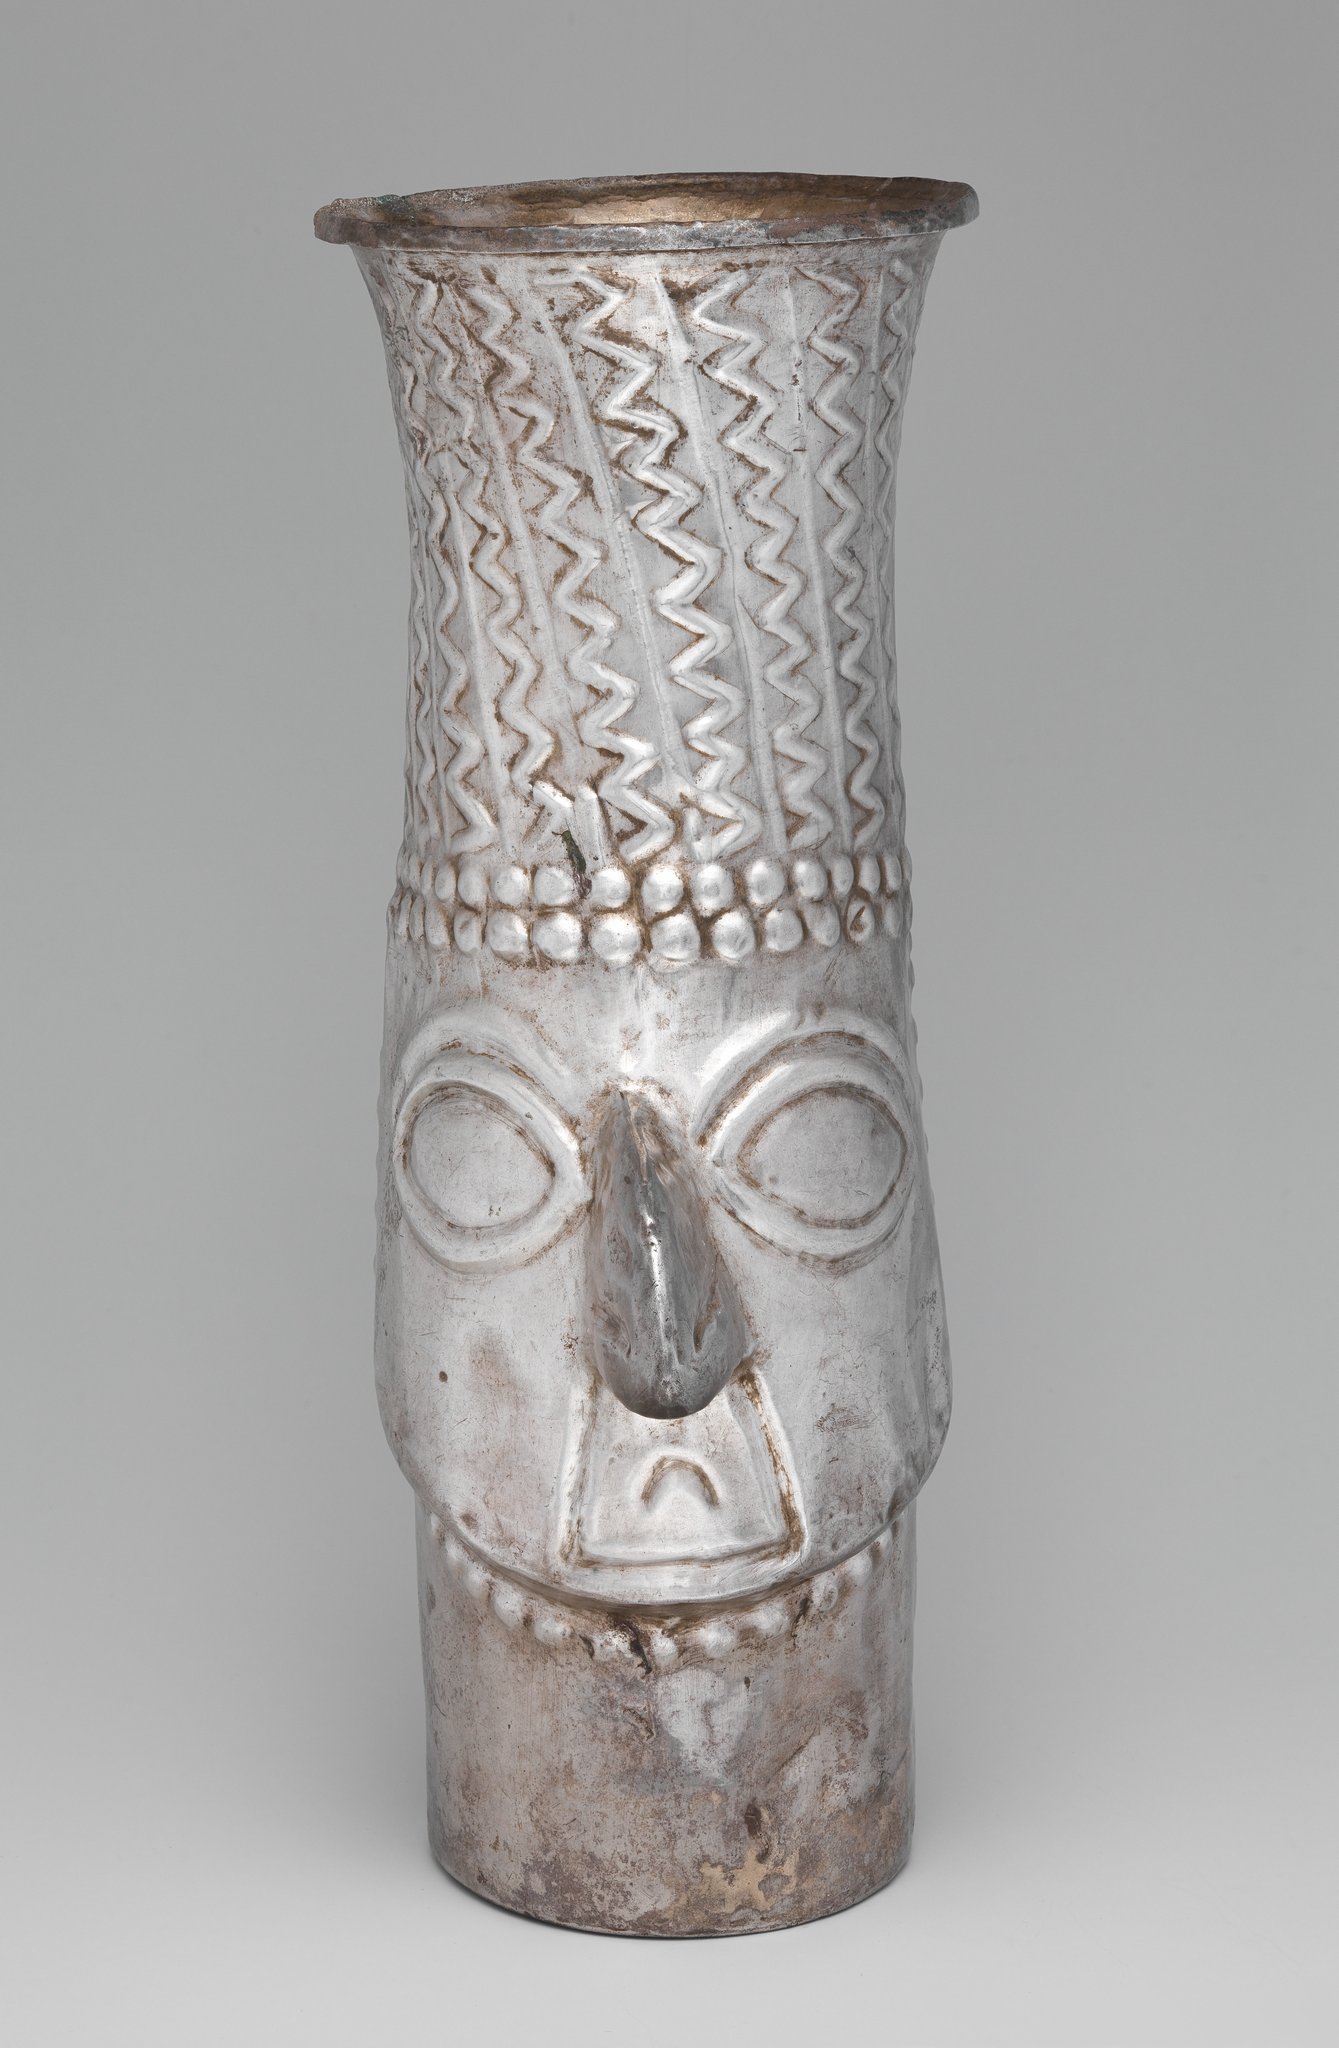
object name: beaker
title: Beaker with face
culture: inca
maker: inca artist(s)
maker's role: artist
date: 1400-1535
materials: silver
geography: peru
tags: faces